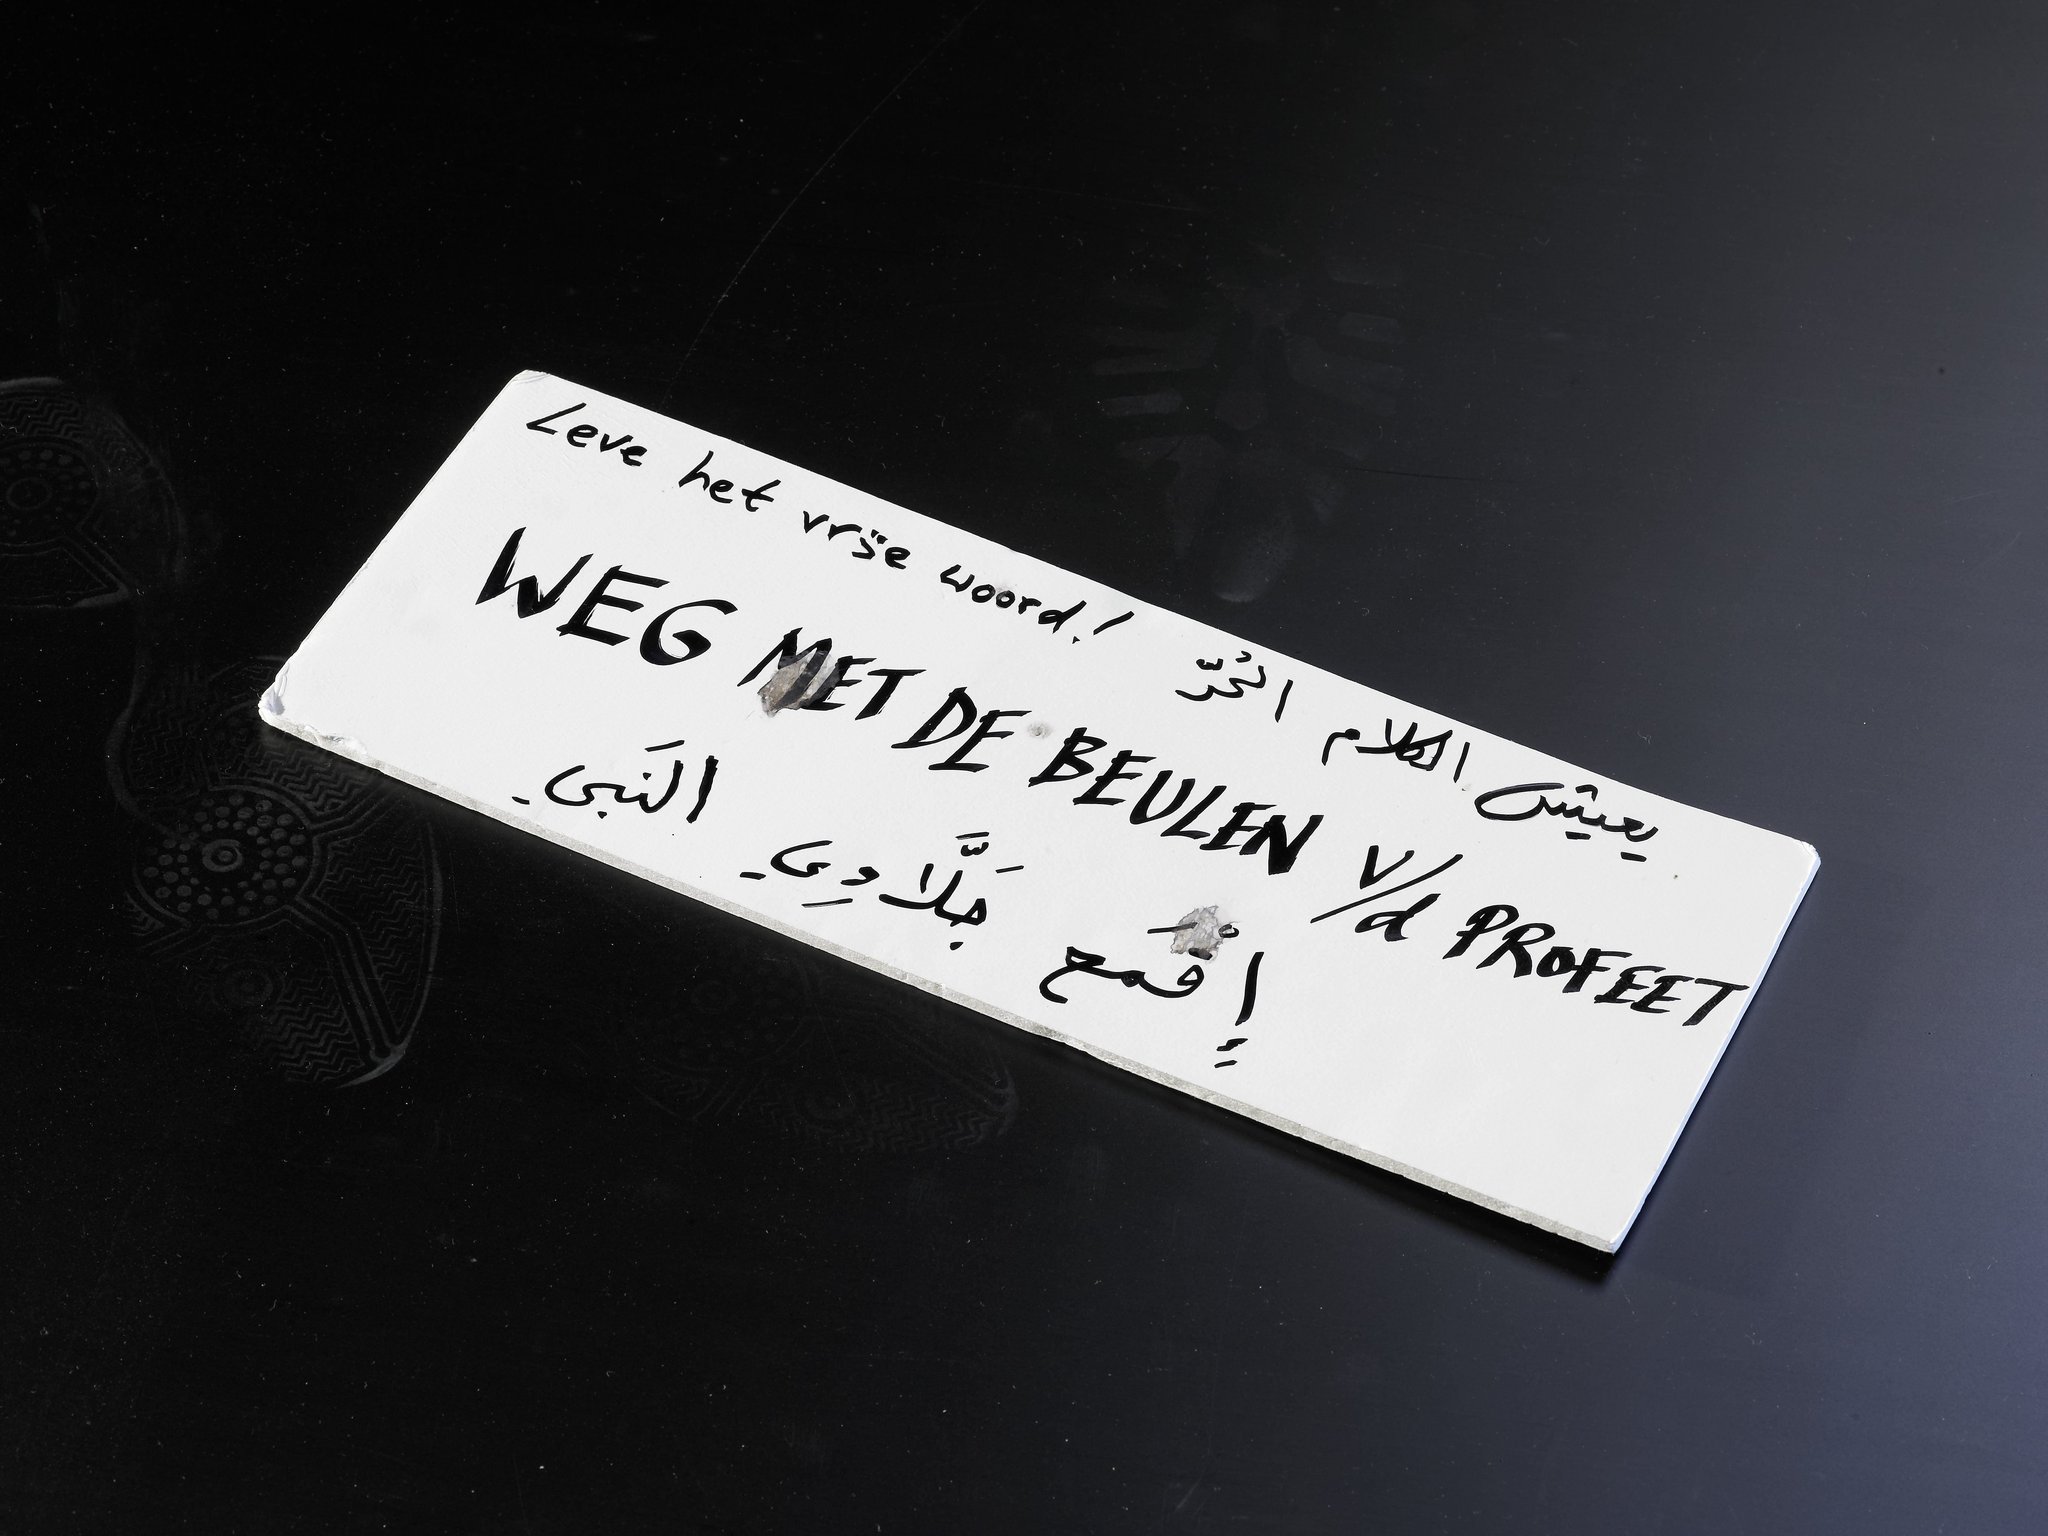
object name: information sign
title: Moord op Theo van Gogh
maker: Anonymous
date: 2004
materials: cardboard, plastic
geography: amsterdam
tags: the hague, amsterdam, theo van gogh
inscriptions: inscription, inscription: ‘Leve het vrije woord! WEG MET DE BEULEN v/d PROFEET’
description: Selectie van negen brieven/ tekeningen die naar aanleiding van de moord op Theo van Gogh op de plek van de moord in de Linnaeusstraat/ hoek Oosterpark, zijn neergelegd. Hier was een herdenkingsplek ingericht.